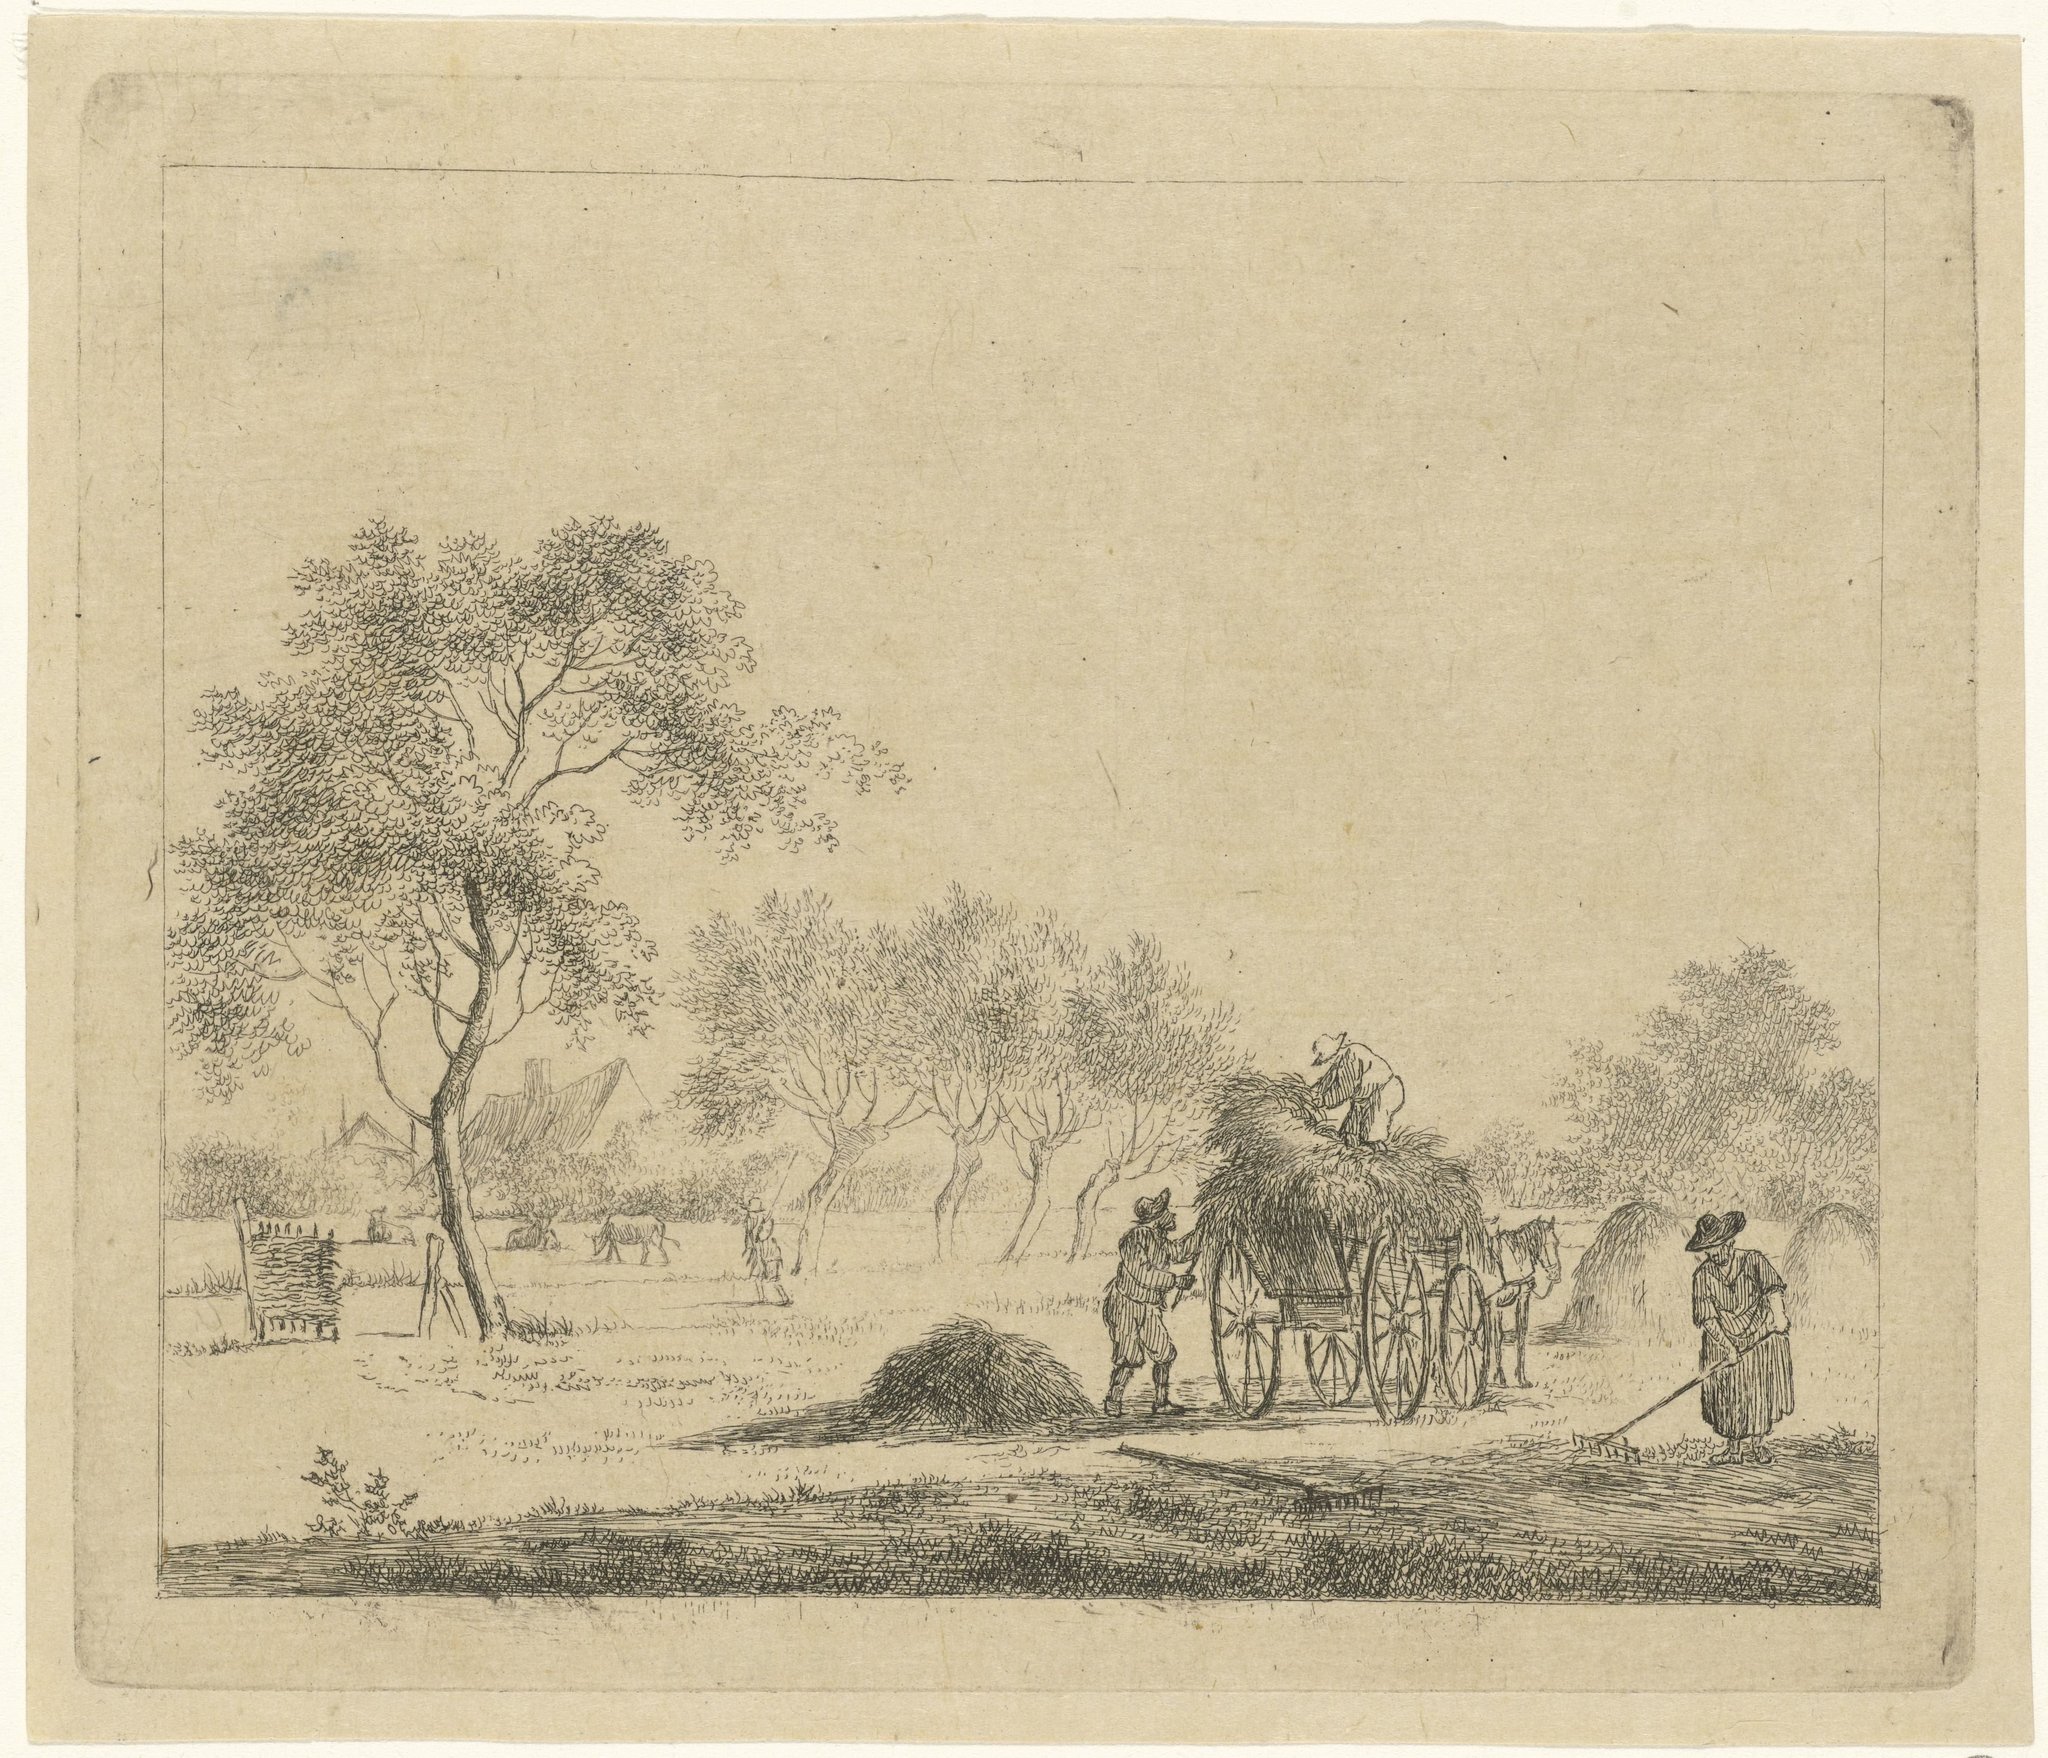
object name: print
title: Juli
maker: johannes janson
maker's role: draughtsman, painter, print maker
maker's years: 1729-1784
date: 1783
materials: paper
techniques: etching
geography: leiden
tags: hay-wagon (+ labourers ~ crafts, industries, agriculture), landscape symbolizing july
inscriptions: collector's mark: Lugt 240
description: Landschap met op de voorgrond een hooiwagen met twee boeren en een boerin met hark. Links op de achtergrond een boerderij, koeien en een boer. Vóór de lucht. Achtste prent uit een serie van dertien met maanden.